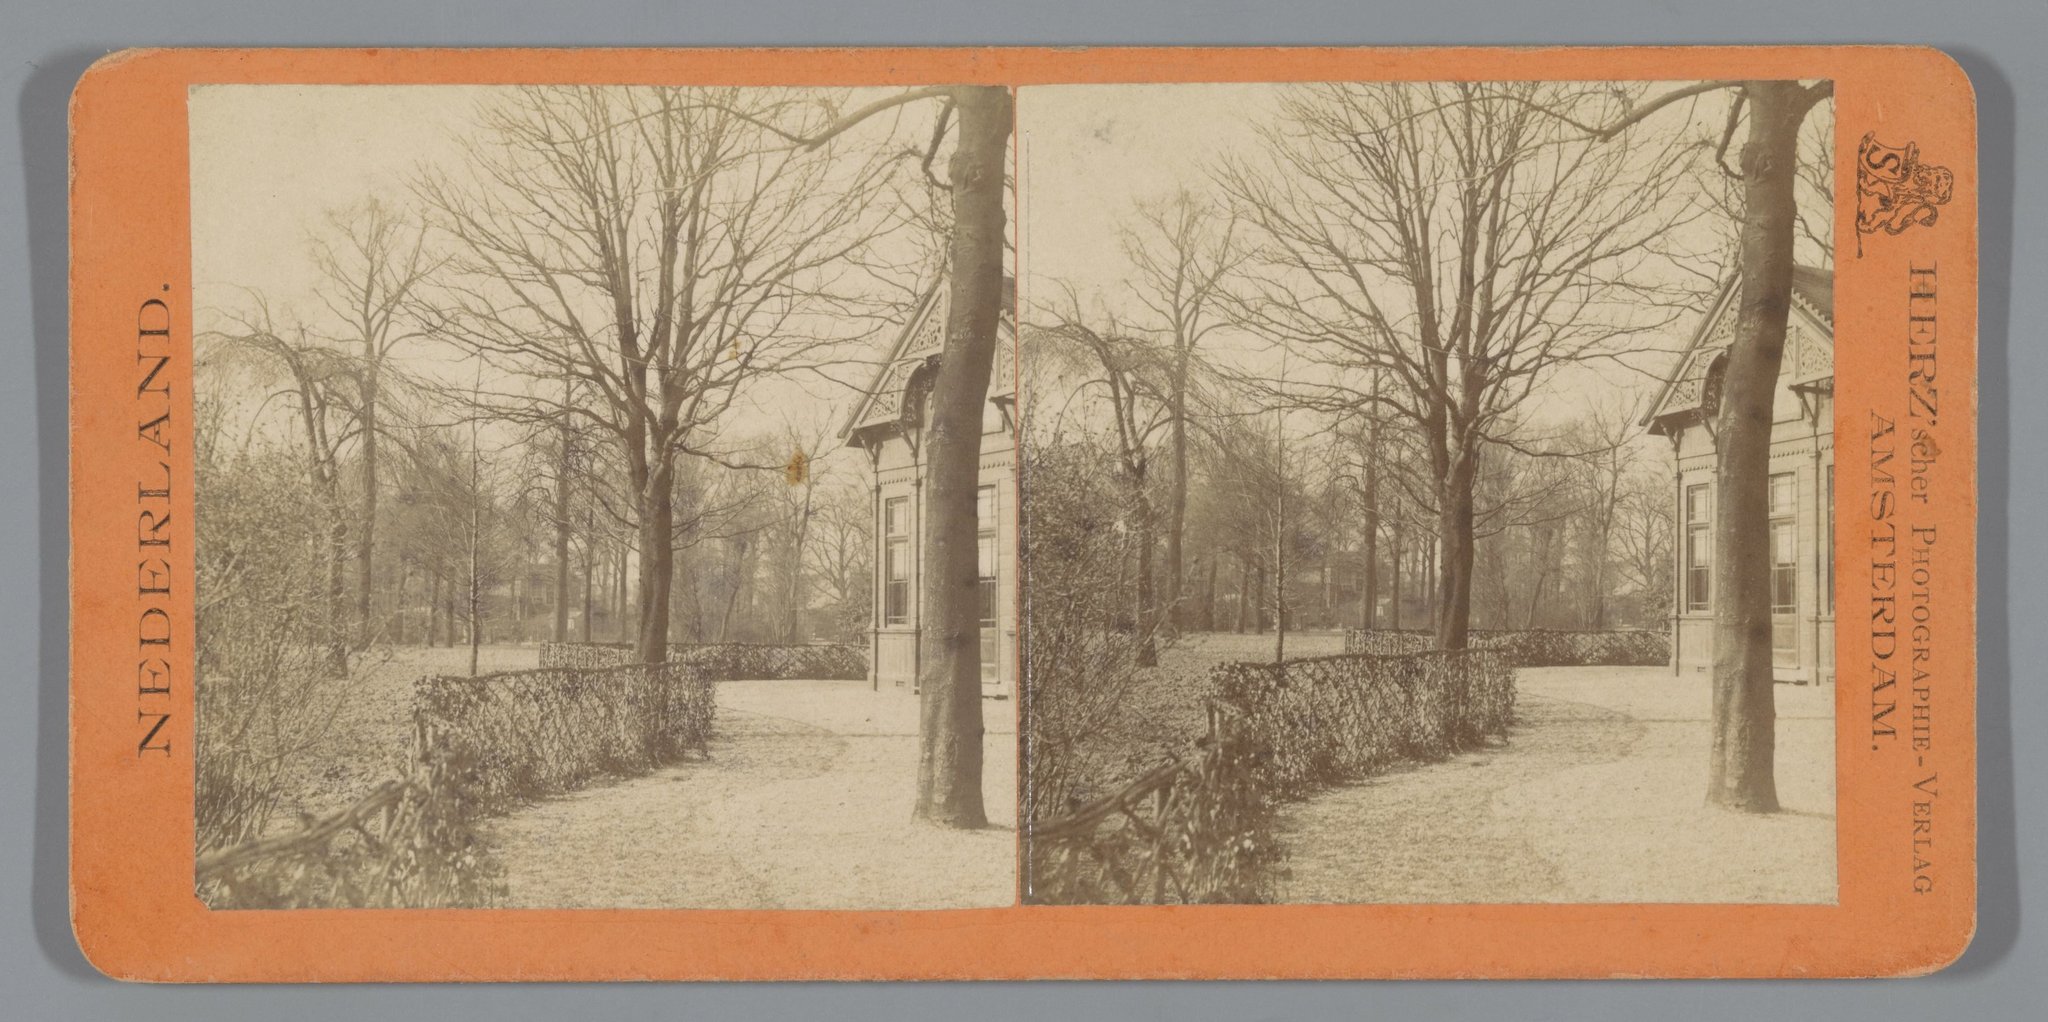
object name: stereograph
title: Vondelpark b/d Kattelaan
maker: sigmund löw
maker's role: publisher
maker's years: 1845-1920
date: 1892-1902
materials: cardboard, paper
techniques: albumen print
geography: amsterdam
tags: park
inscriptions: retailer's mark: ‘Gebr. Douwes/ Ateliers/ Warmoesstraat 73/ Amsterdam’, number: ‘573’